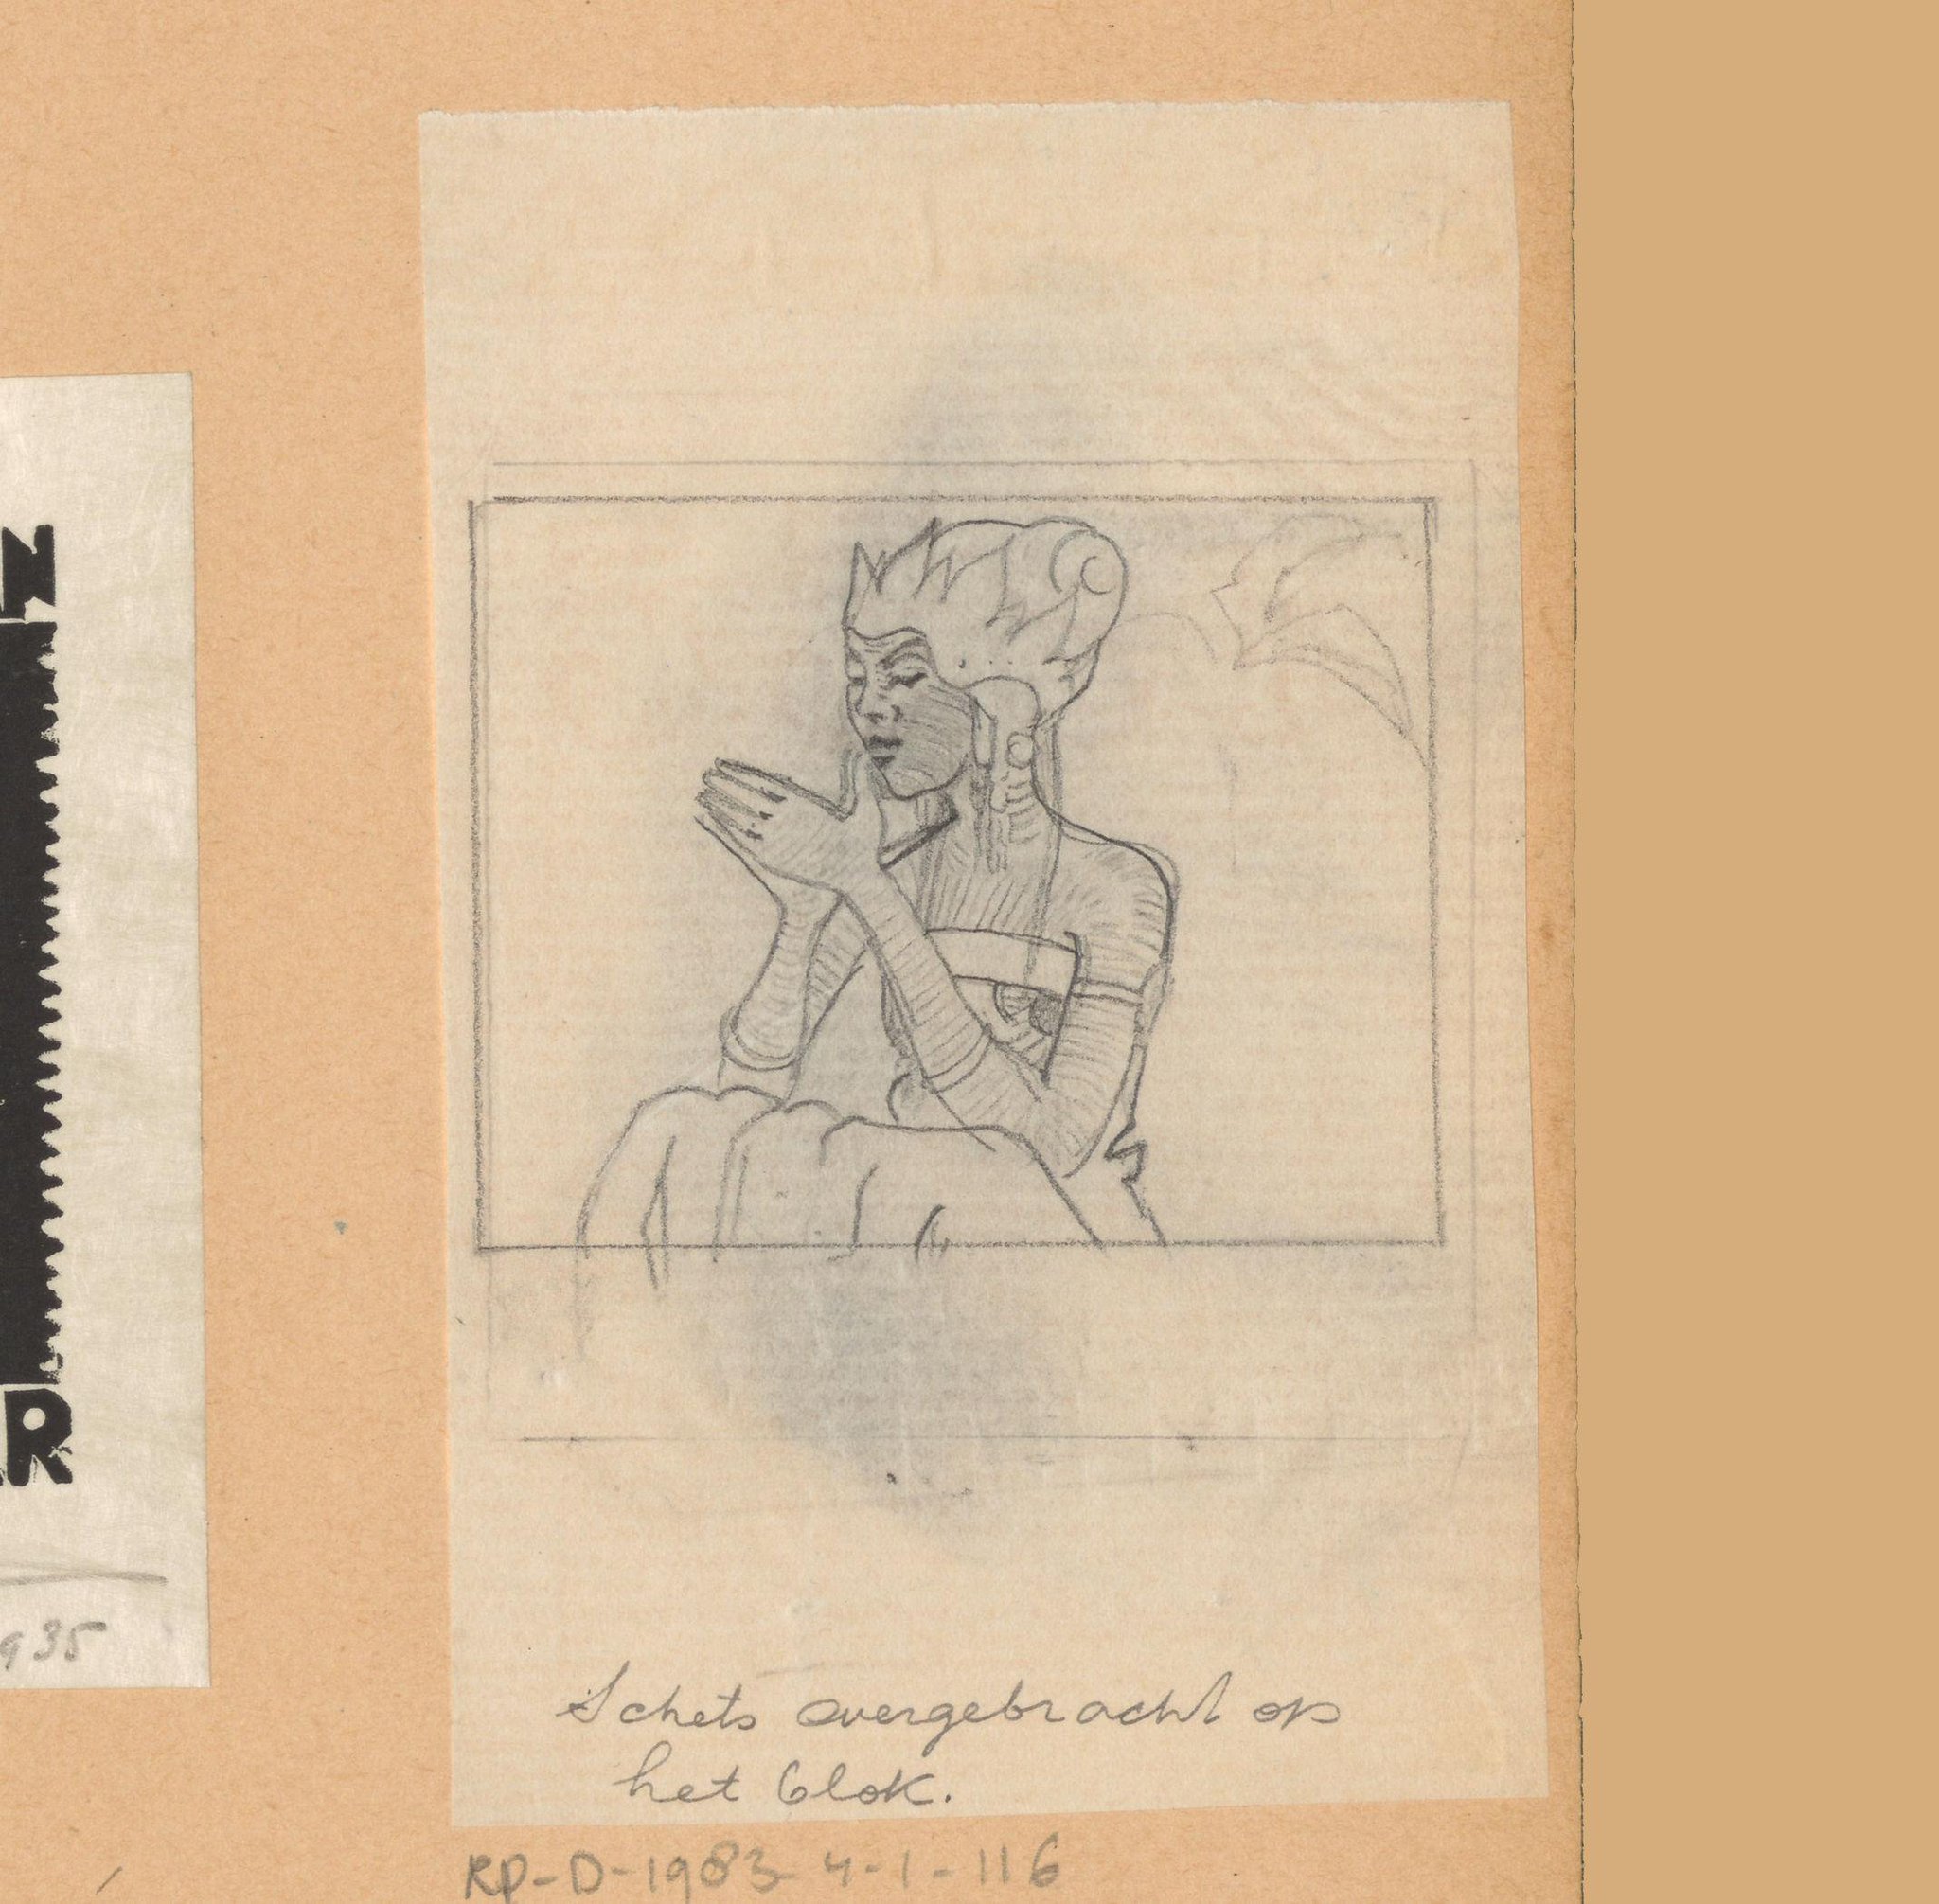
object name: bookplate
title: Ontwerptekening voor ex libris van Dodo en Jan Bennink-Inklaar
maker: otto verhagen (i)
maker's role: draughtsman, print maker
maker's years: 1885-1951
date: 1912-1935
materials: paper, pencil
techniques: drawing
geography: netherlands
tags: adolescent, young woman, maiden, folk costume, regional costume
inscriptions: inscription: ‘Schets overgebracht op/ het blok’